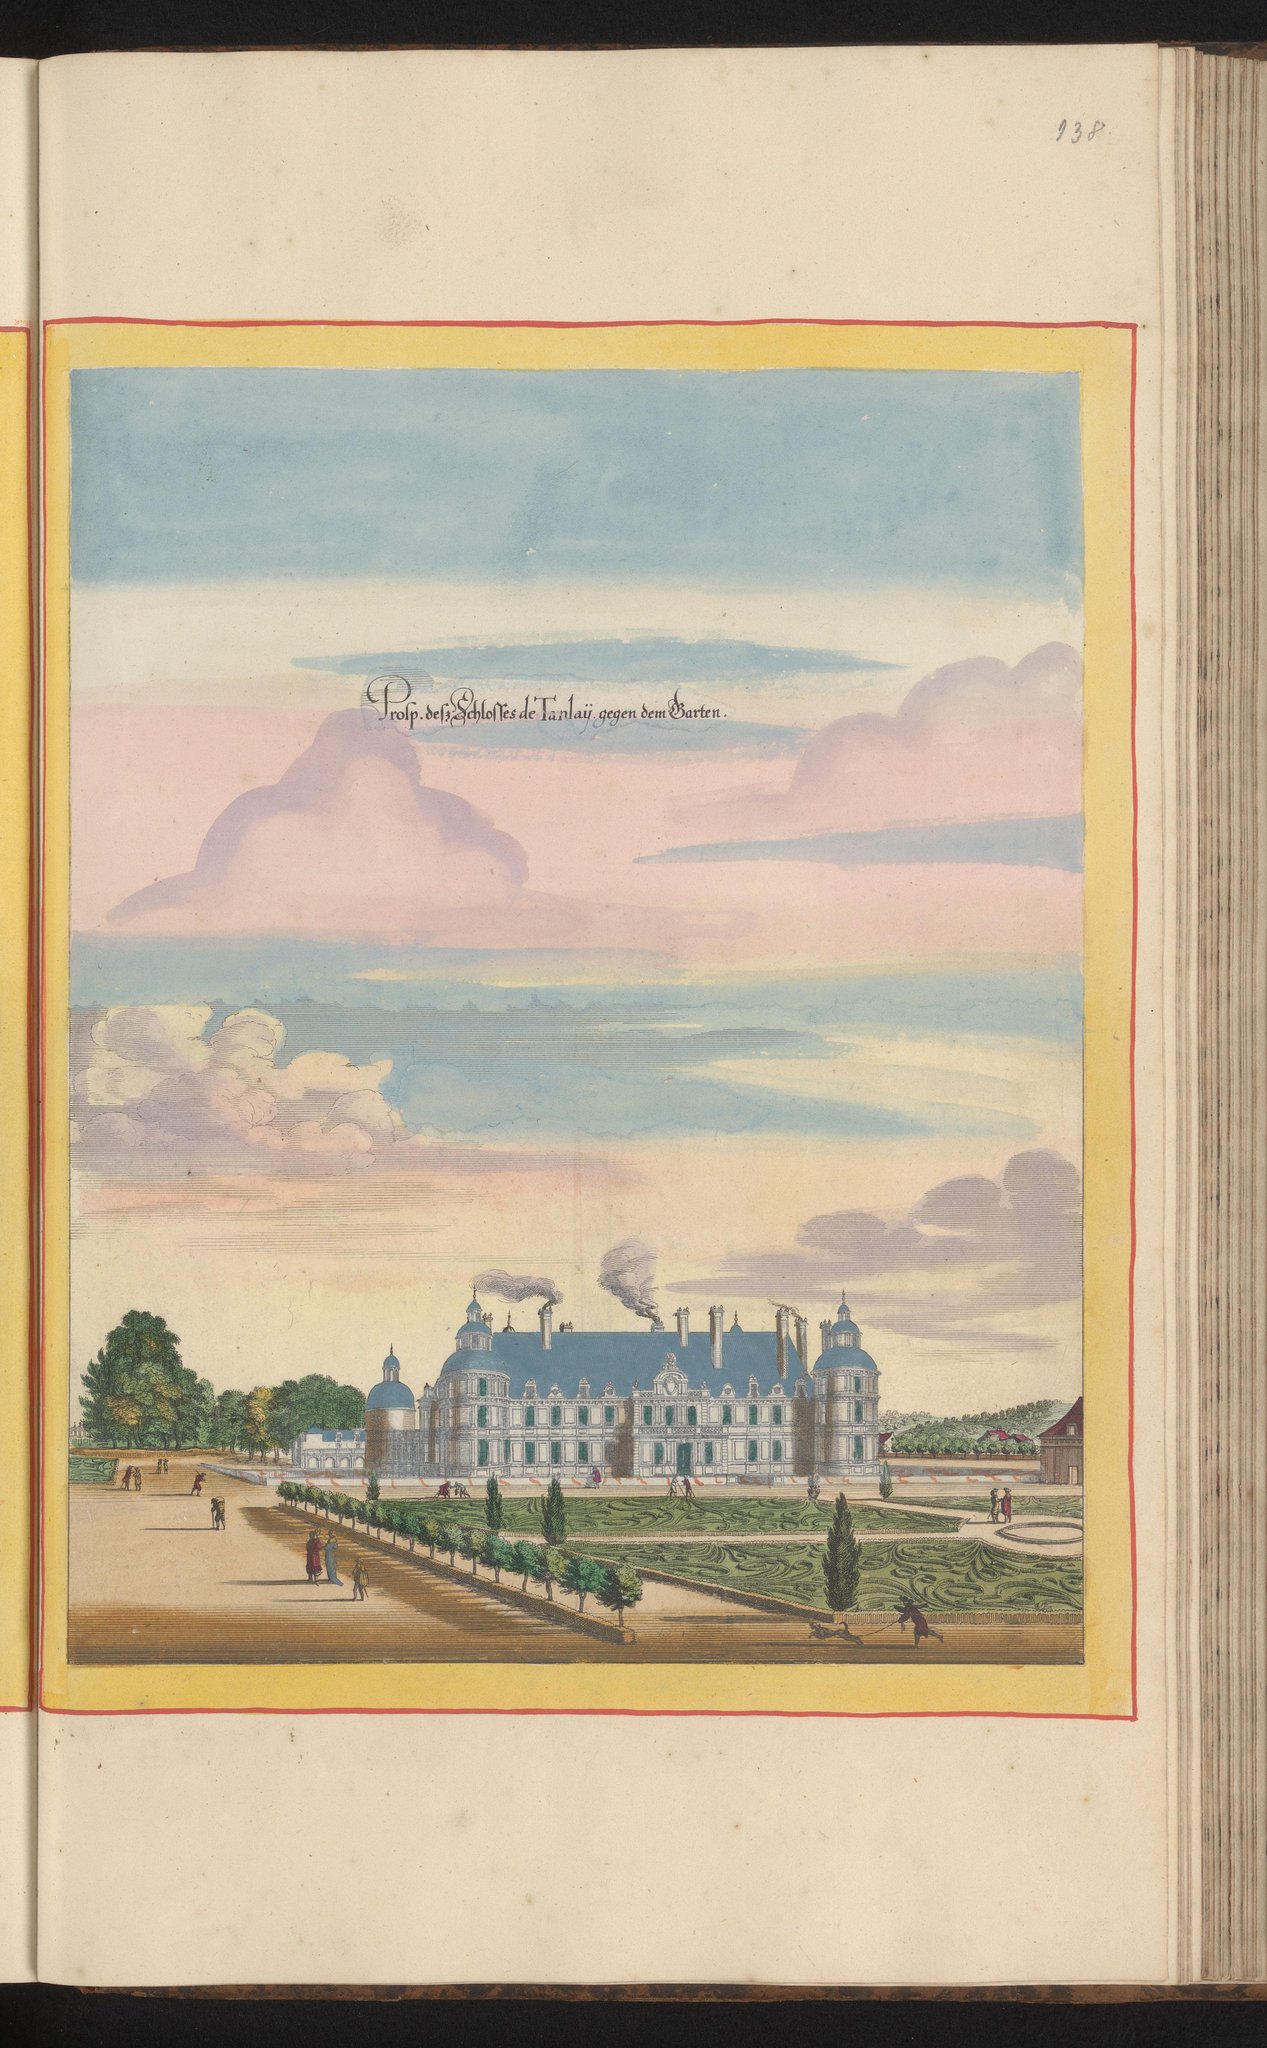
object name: album leaf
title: Prosp. dess Schlosses de Tanlaij gegen dem Garten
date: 1656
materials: paper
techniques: engraving, etching, hand coloring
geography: frankfurt am main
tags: city-view in general; 'veduta'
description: Prent uit: Zeiller, Martin. Topographia Galliae. 13 dln. Frankfurt: Caspar Merian, 1656, dl. 3, na p. 32.